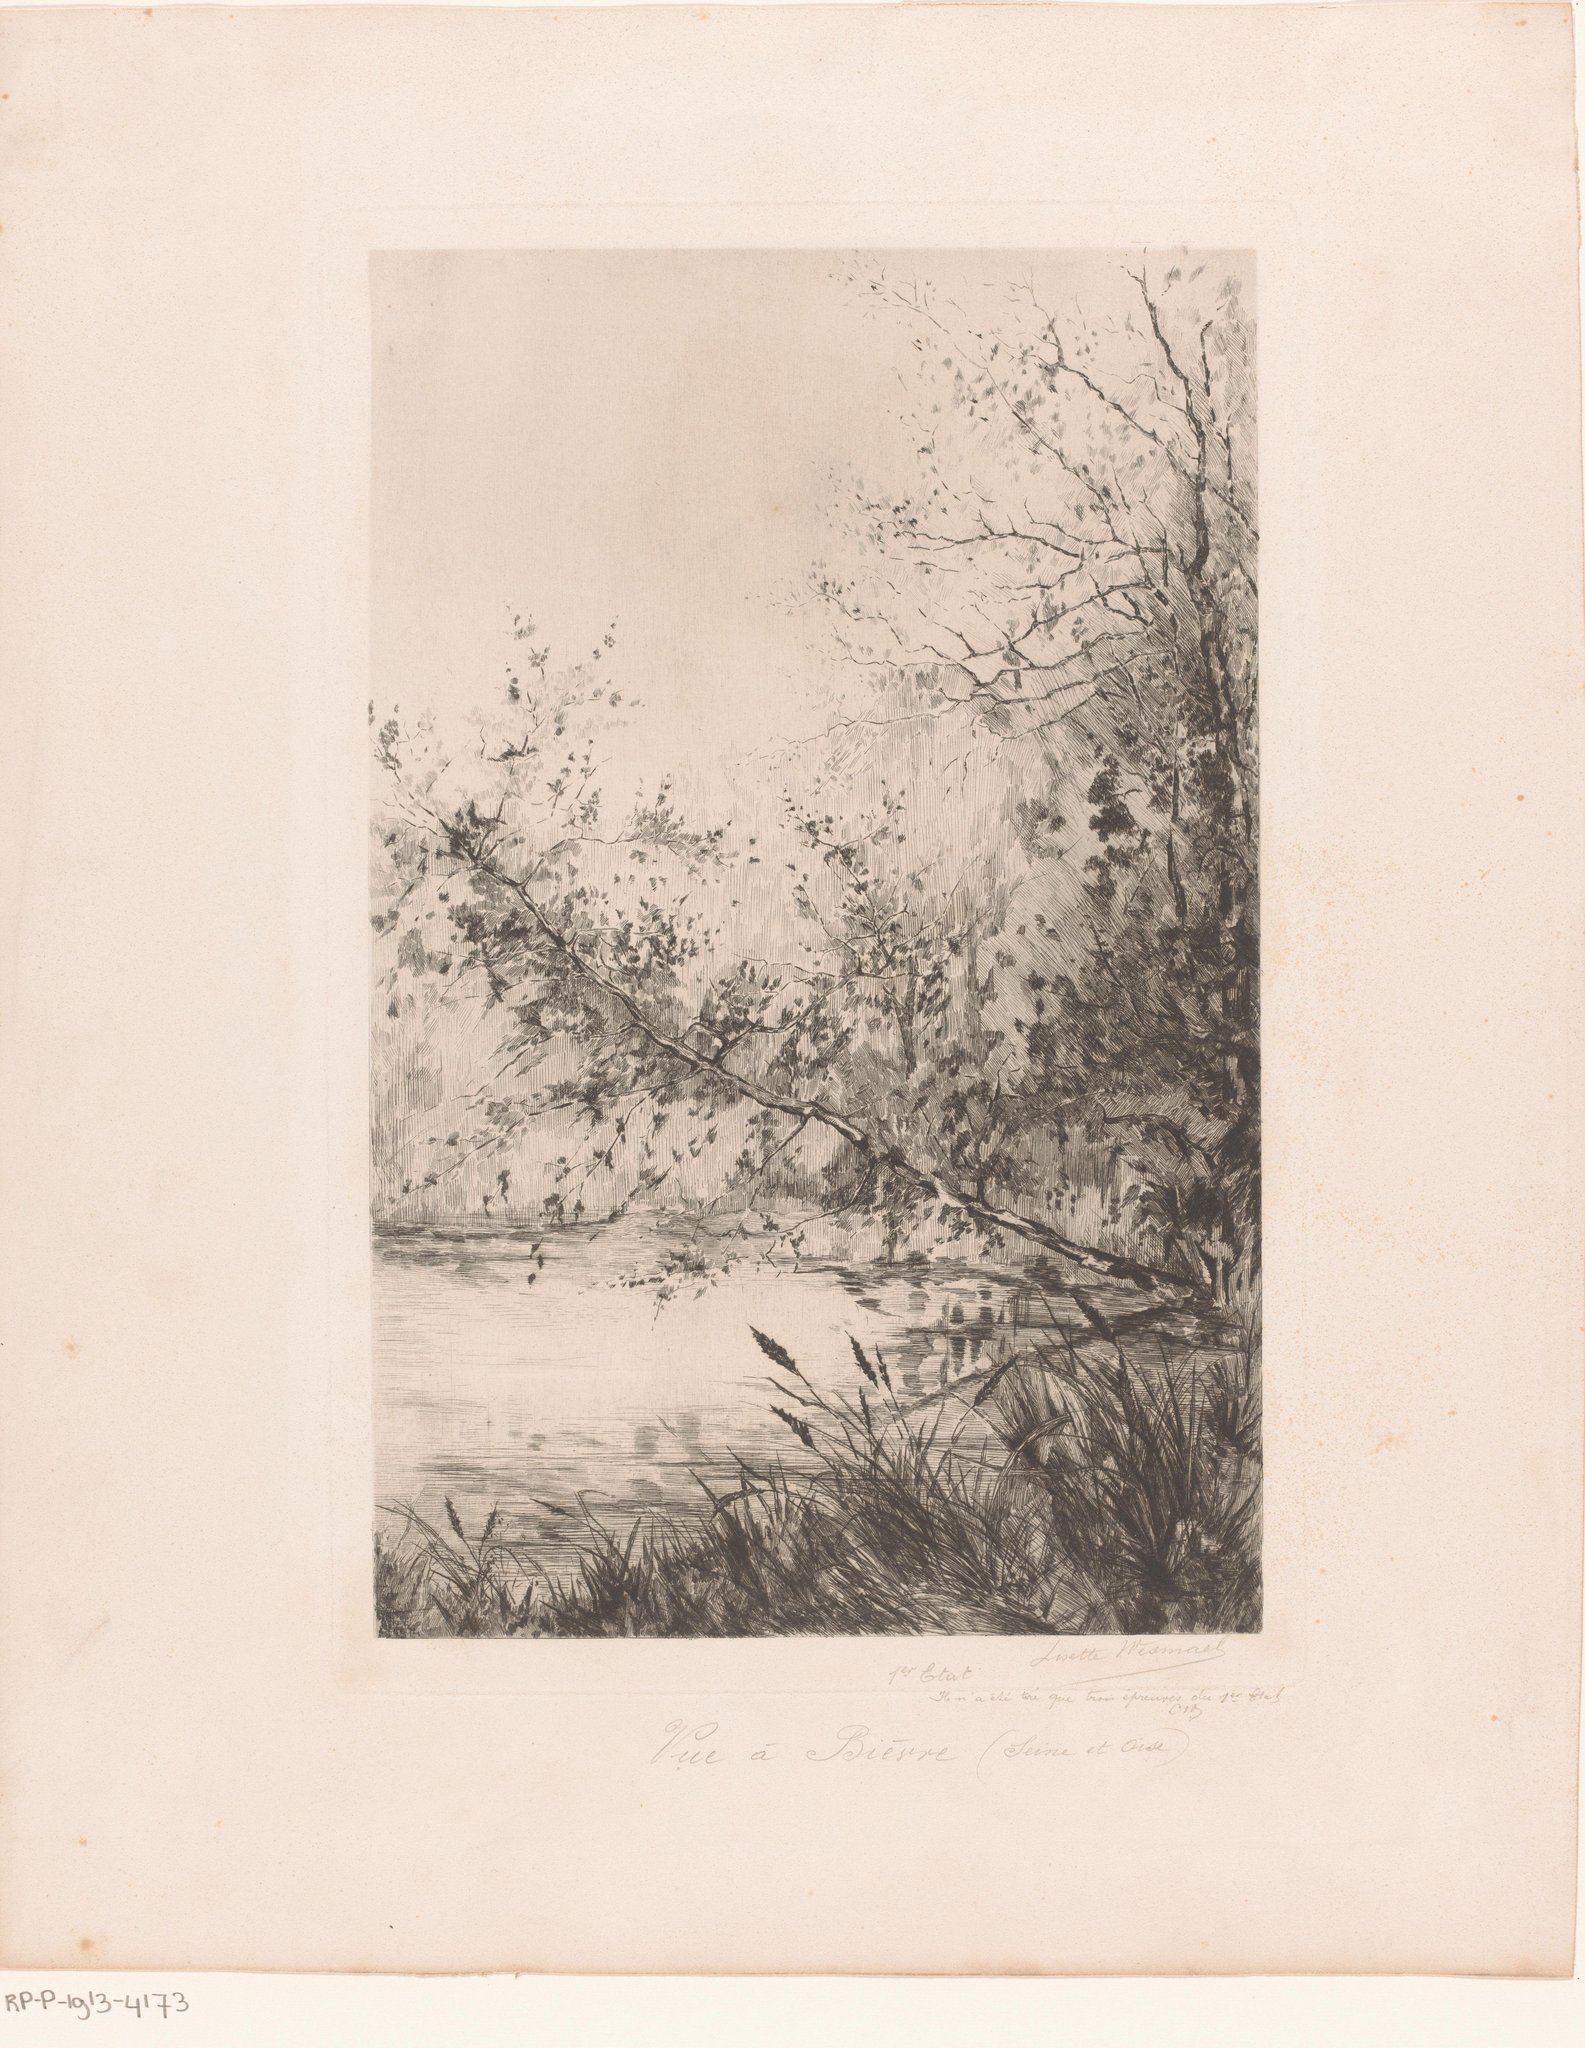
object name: print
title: Landschap met de rivier de Bièvre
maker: lisette wesmael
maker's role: print maker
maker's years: 1861-1953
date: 1883-1913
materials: paper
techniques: drypoint, etching, intaglio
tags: river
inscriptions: annotation: ‘Il n'a été tiré que trois épreuves du 1.er Etat/ L [...]’, collector's mark: Lugt 2228